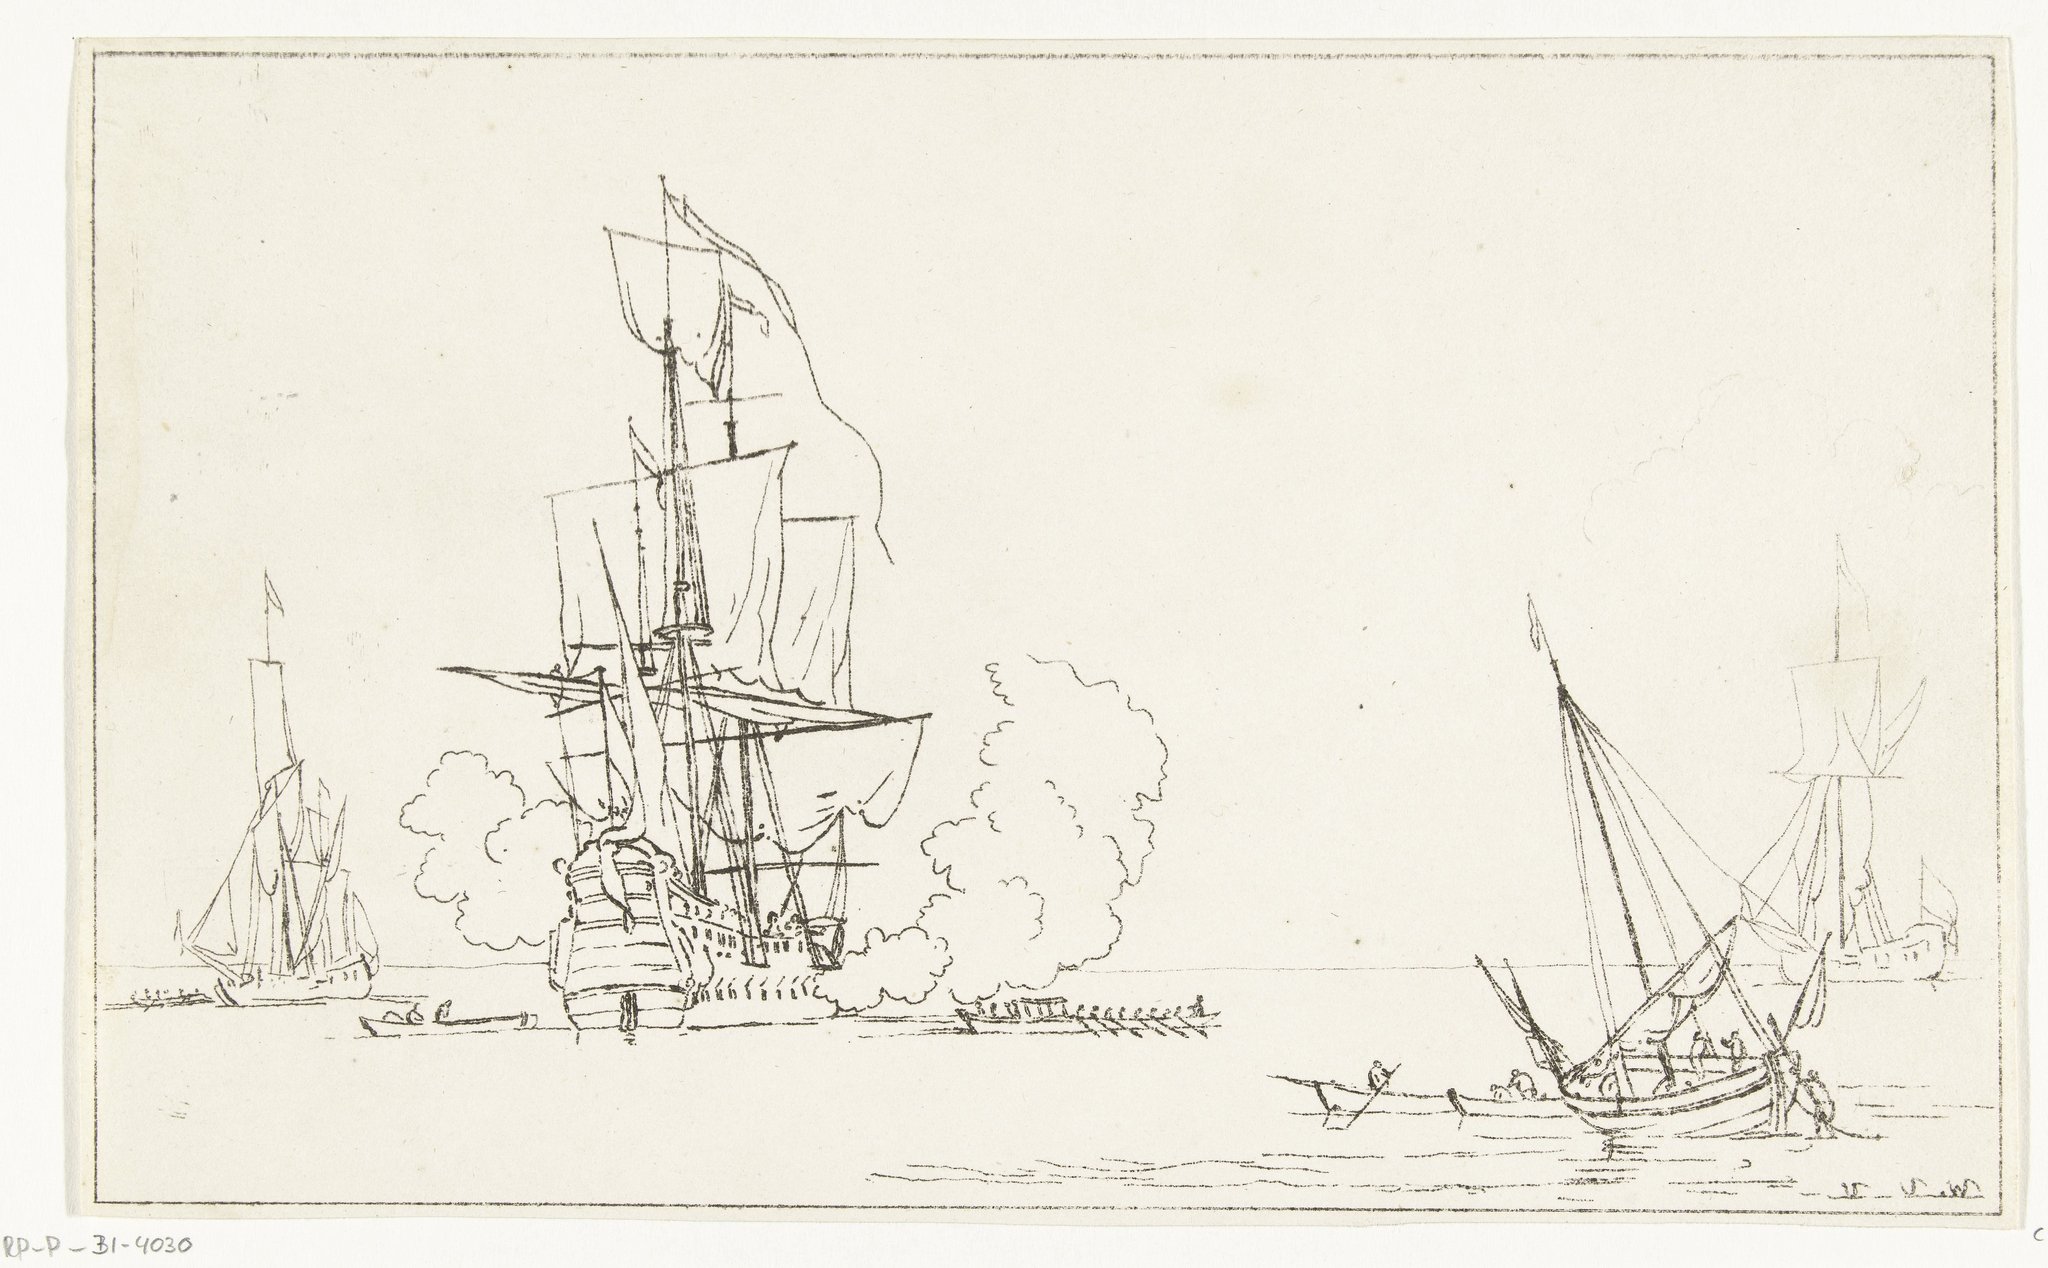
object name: print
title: Zeeslag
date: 1778-1832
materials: paper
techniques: printmaking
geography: netherlands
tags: battle (+ sailing-ships)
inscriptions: collector's mark: Lugt 2228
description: Een oorlogsschip bij windstilte met slappe zeilen lost een kanonschot. Aan weerszijden twee sloepen, in de verte twee kleinere schepen. Een ander schip wordt door de bemanning aan het strand getrokken.